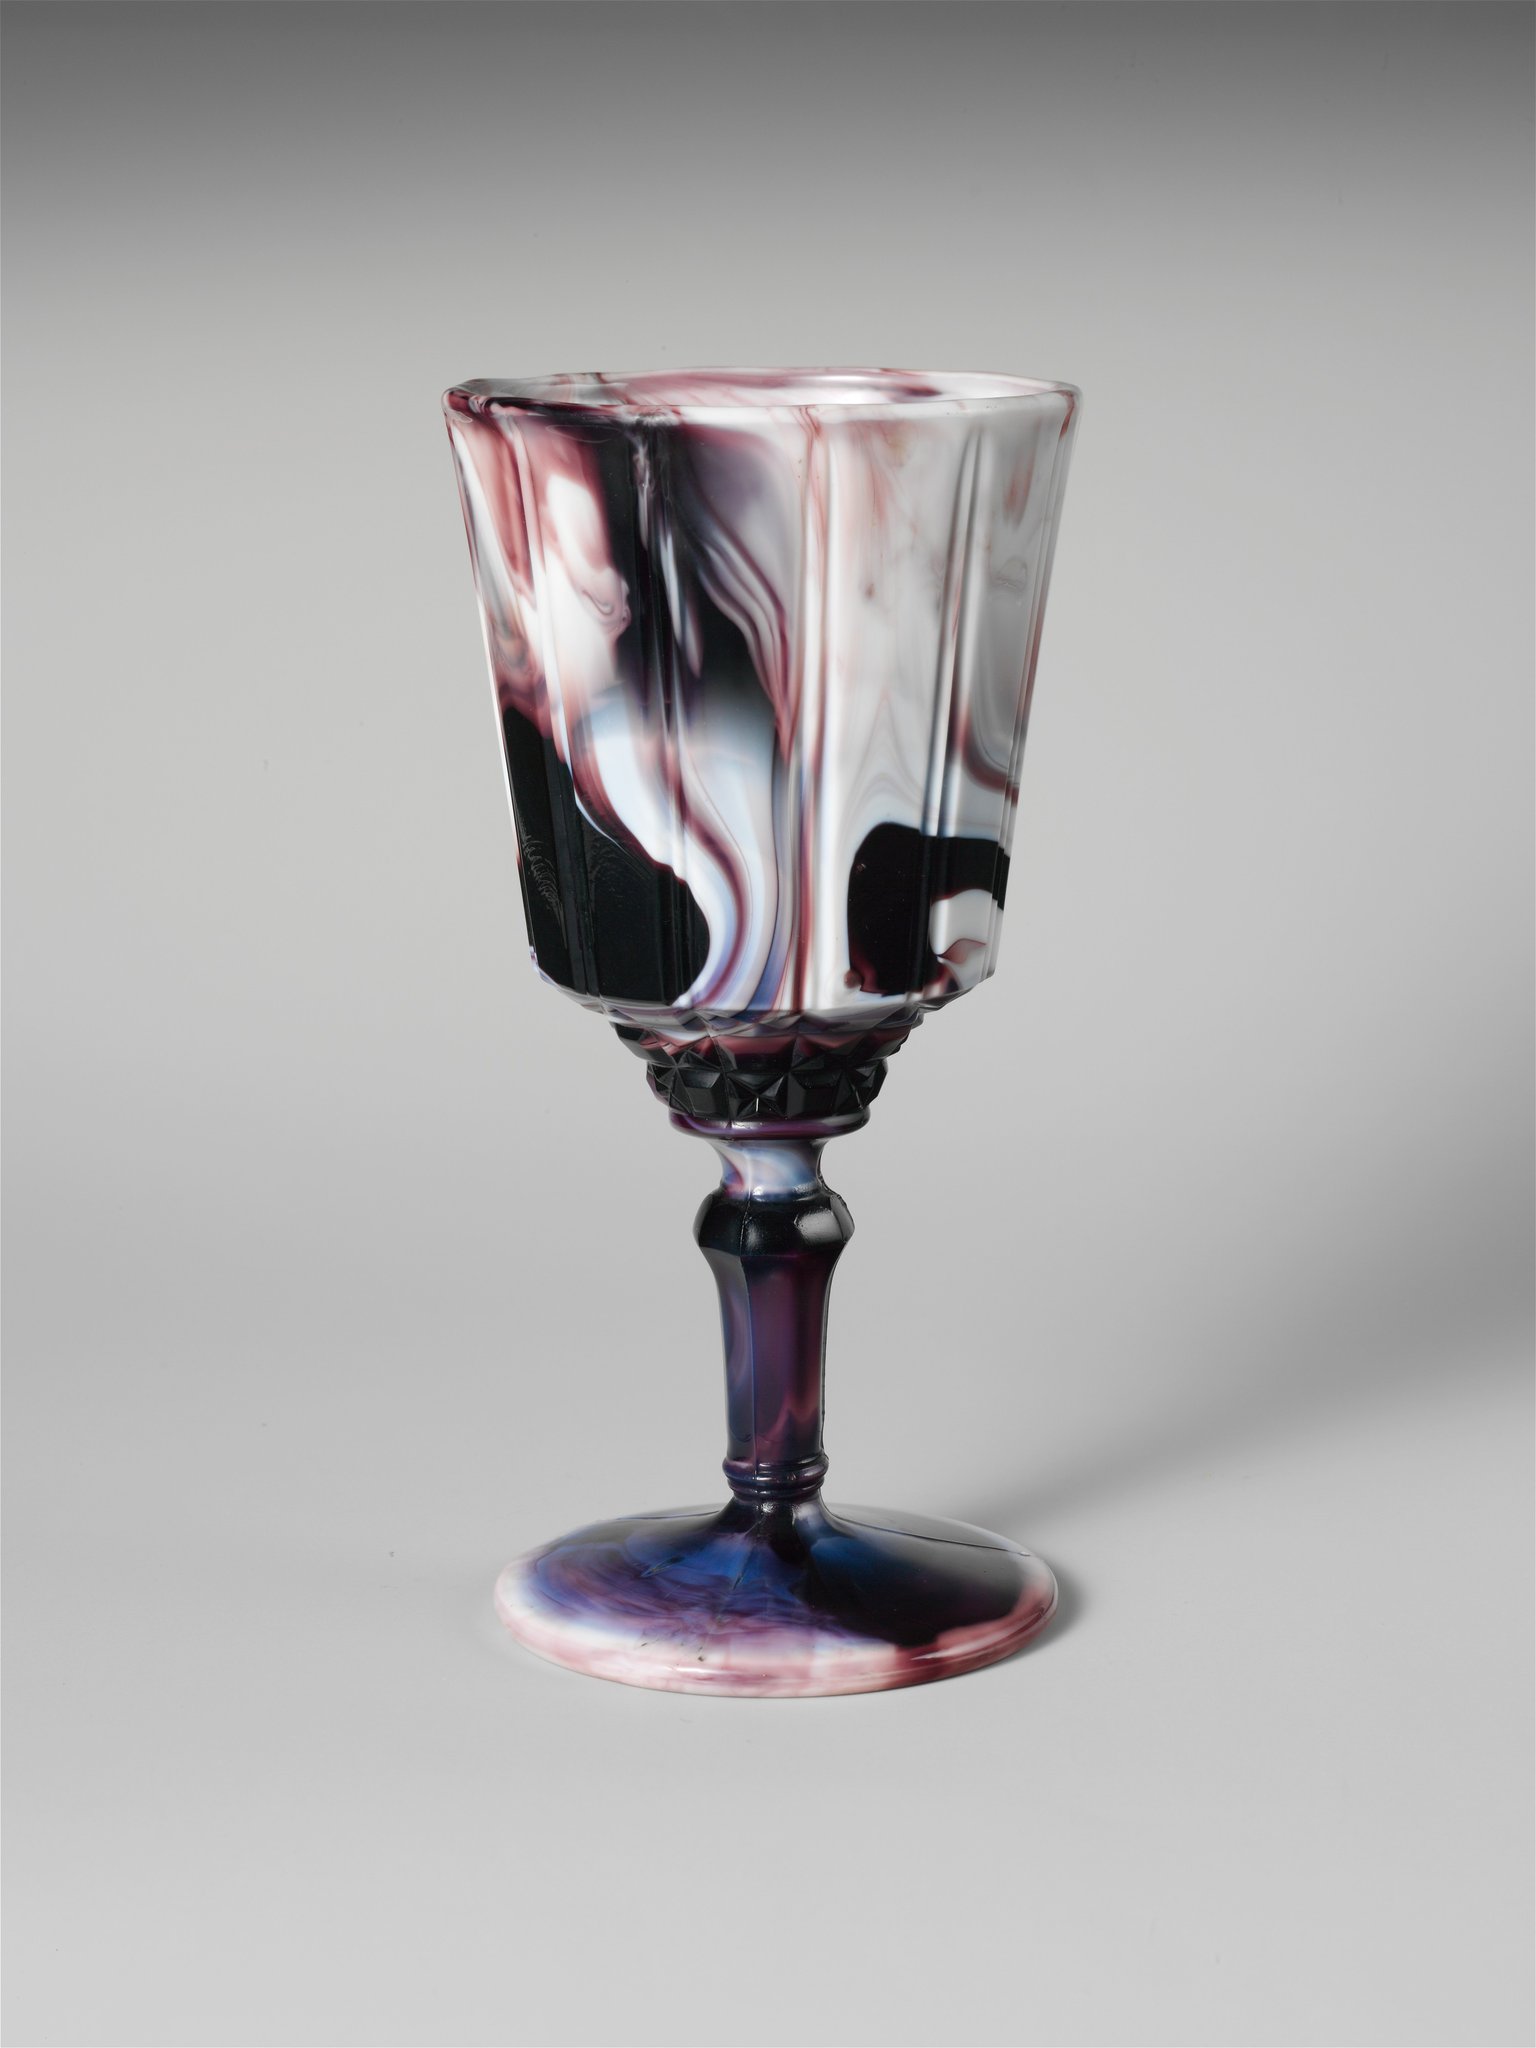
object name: goblet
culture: american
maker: challinor, taylor and company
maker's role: maker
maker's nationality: american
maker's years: 1866-1891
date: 1870-1890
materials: glass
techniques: pressed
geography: united states